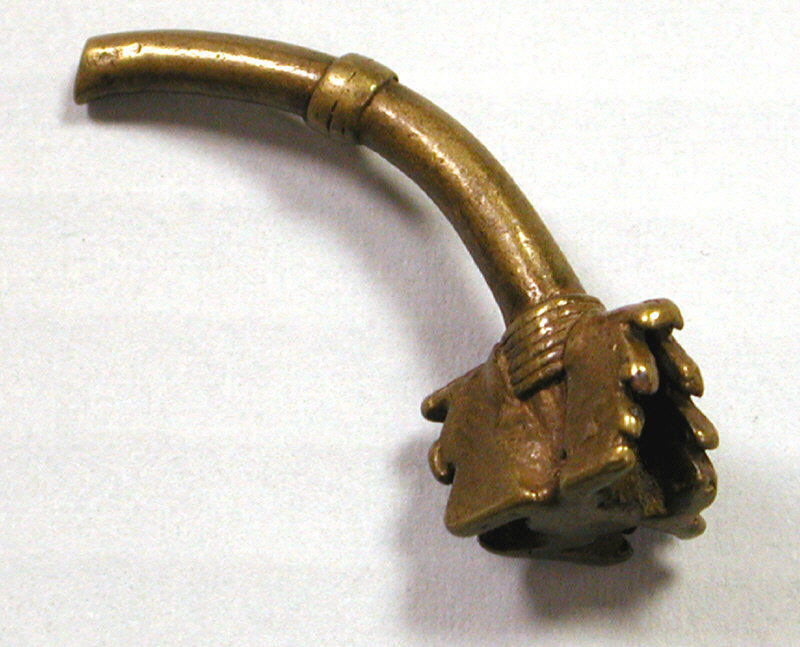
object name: weight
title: Gold Weight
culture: akan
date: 1701-1900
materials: brass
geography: ghana